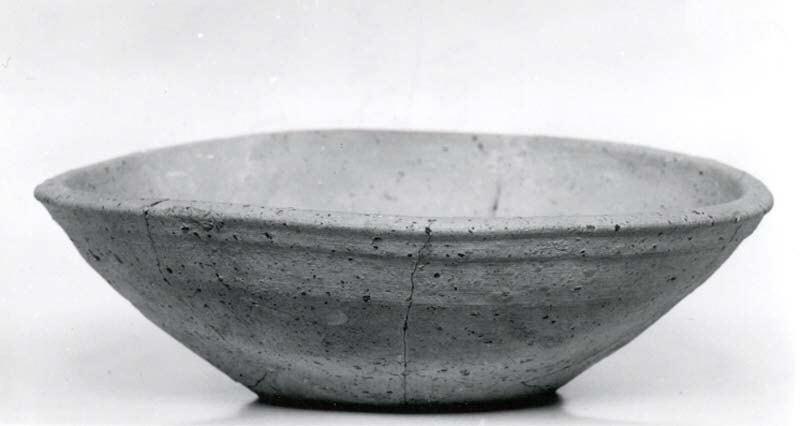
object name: bowl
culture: sasanian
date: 201-700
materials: ceramic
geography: iran